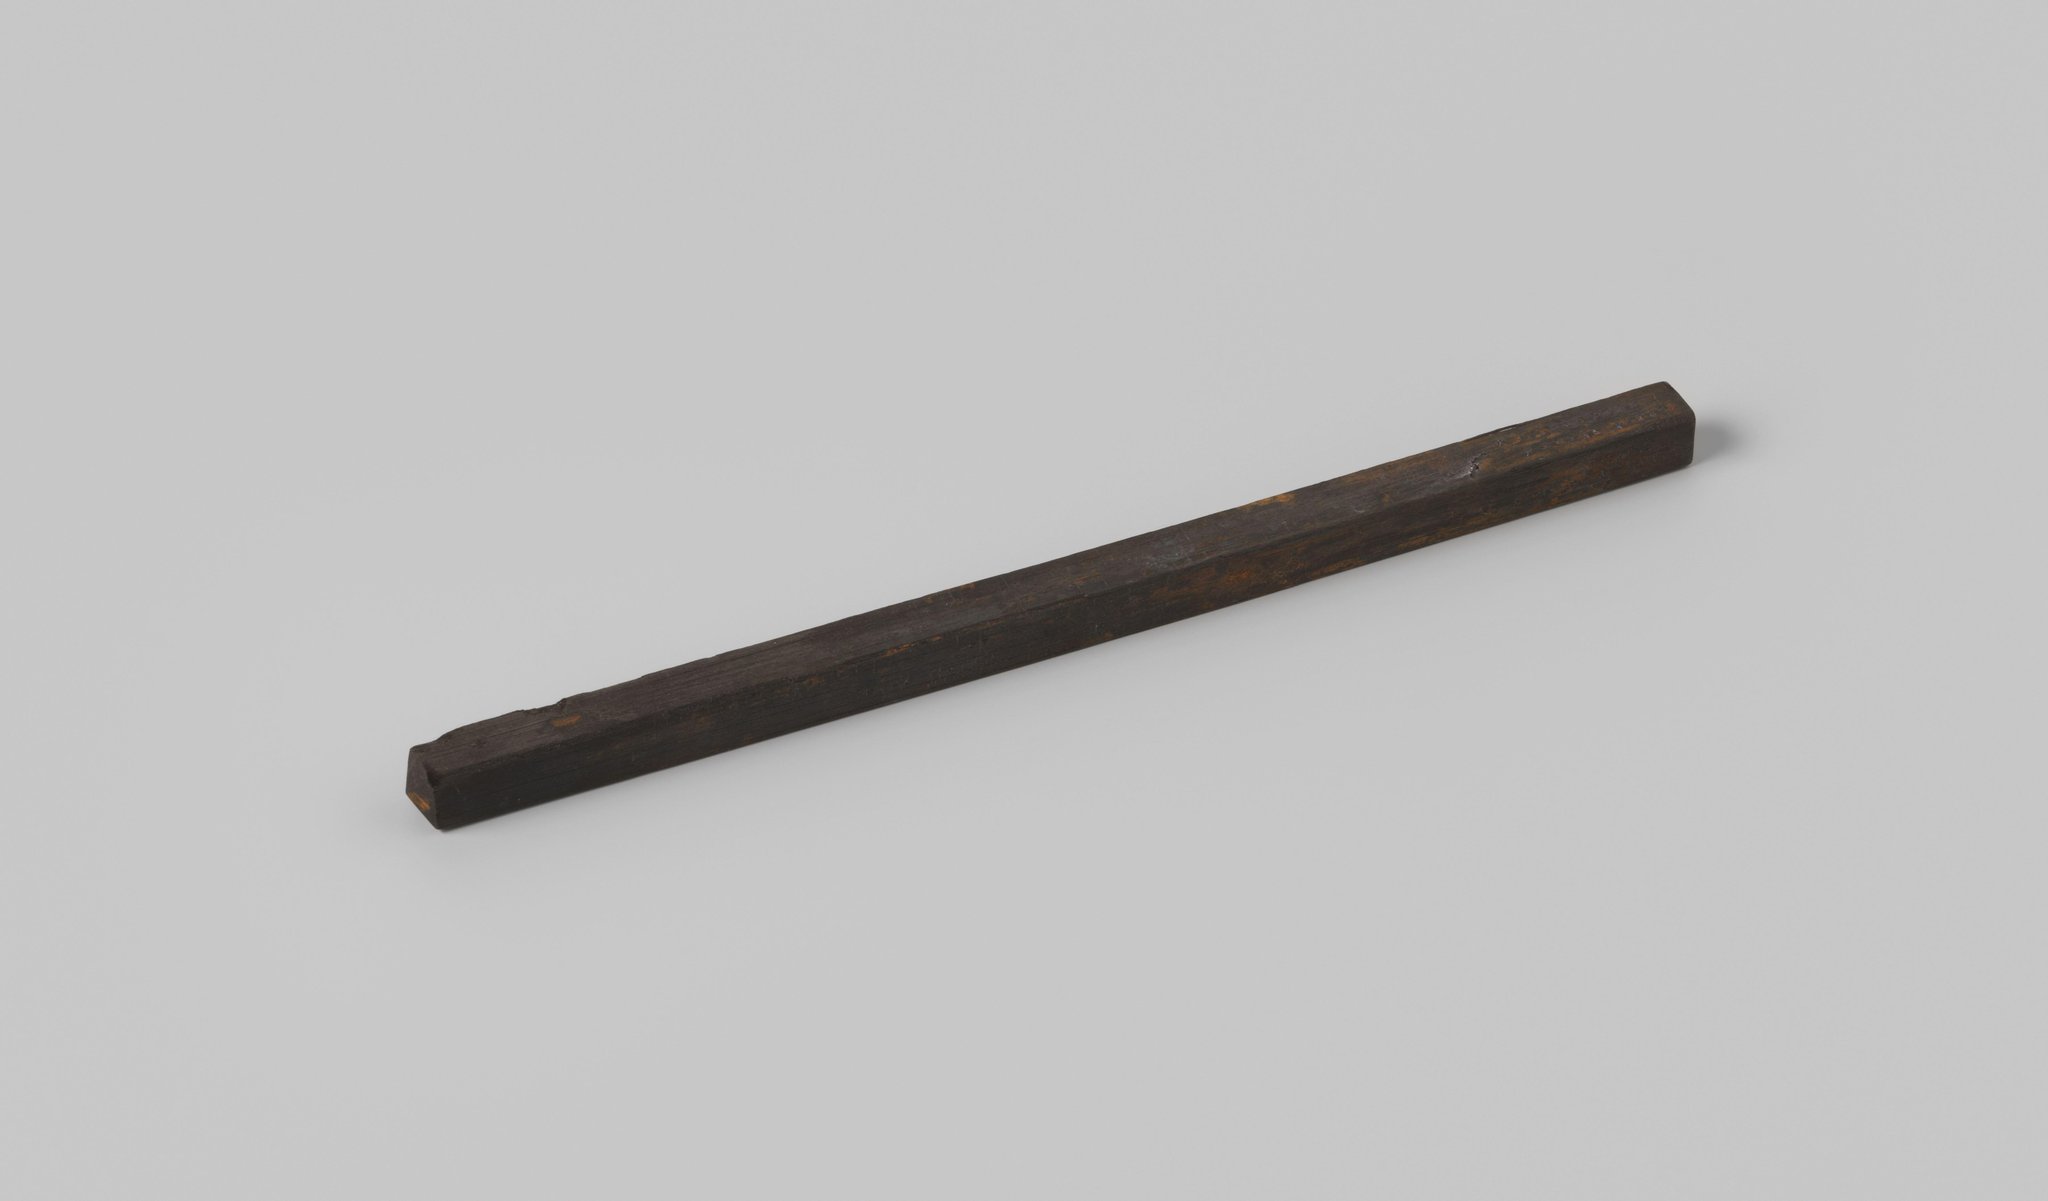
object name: board rule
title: Talstok uit het wrak van de Oost-Indiëvaarder 't Vliegend Hart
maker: Anonymous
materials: wood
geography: middelburg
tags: 't vliegend hart (schip), verenigde oostindische compagnie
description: Houten langwerpige rechthoekige stok met aangegeven maten. Tallystick.